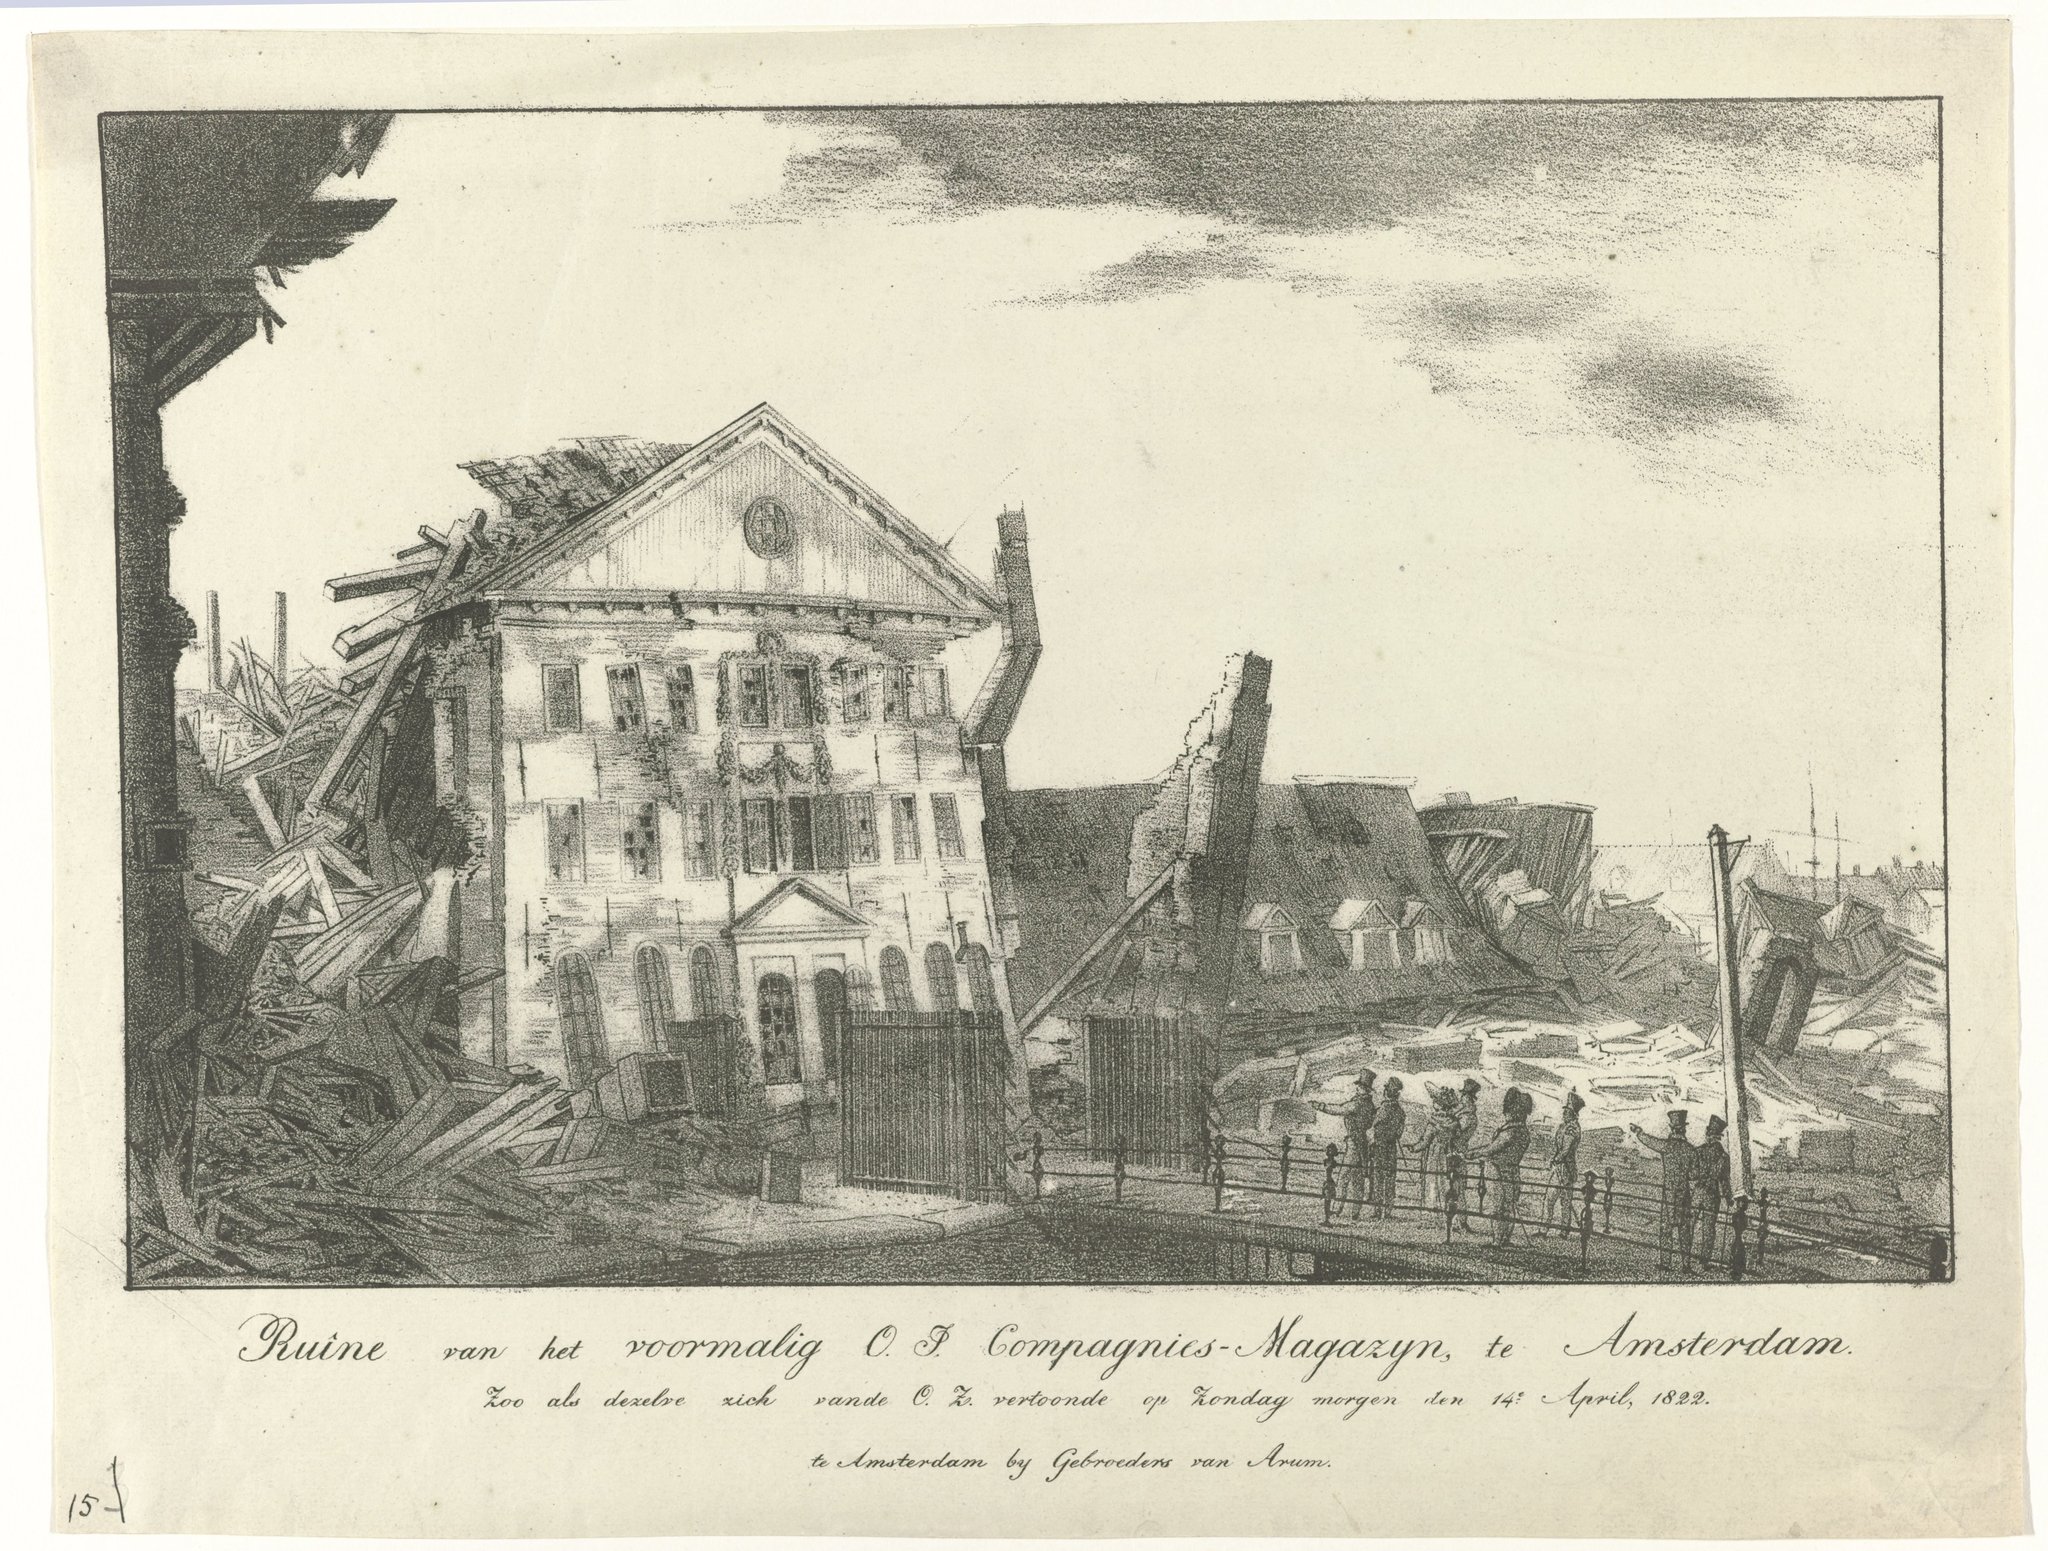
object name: print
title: Ruine van het voormalig O.I. Compagnies-Magazyn, te Amsterdam. Zoo als dezelve zich vande o.z. vertoonde op Zondag morgen den 14e April, 1822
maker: jacob plügger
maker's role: print maker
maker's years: 1795-1871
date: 1822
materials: paper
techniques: lithograph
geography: amsterdam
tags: ruin of a building ~ architecture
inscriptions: collector's mark: Lugt 2228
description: Ruïne van het Oost-Indisch Zeemagazijn te Amsterdam, na de instorting op 13-14 april 1822. Gezicht van de oostzijde. Zie ook de pendant en de bijbehorende afzonderlijke verklaring.